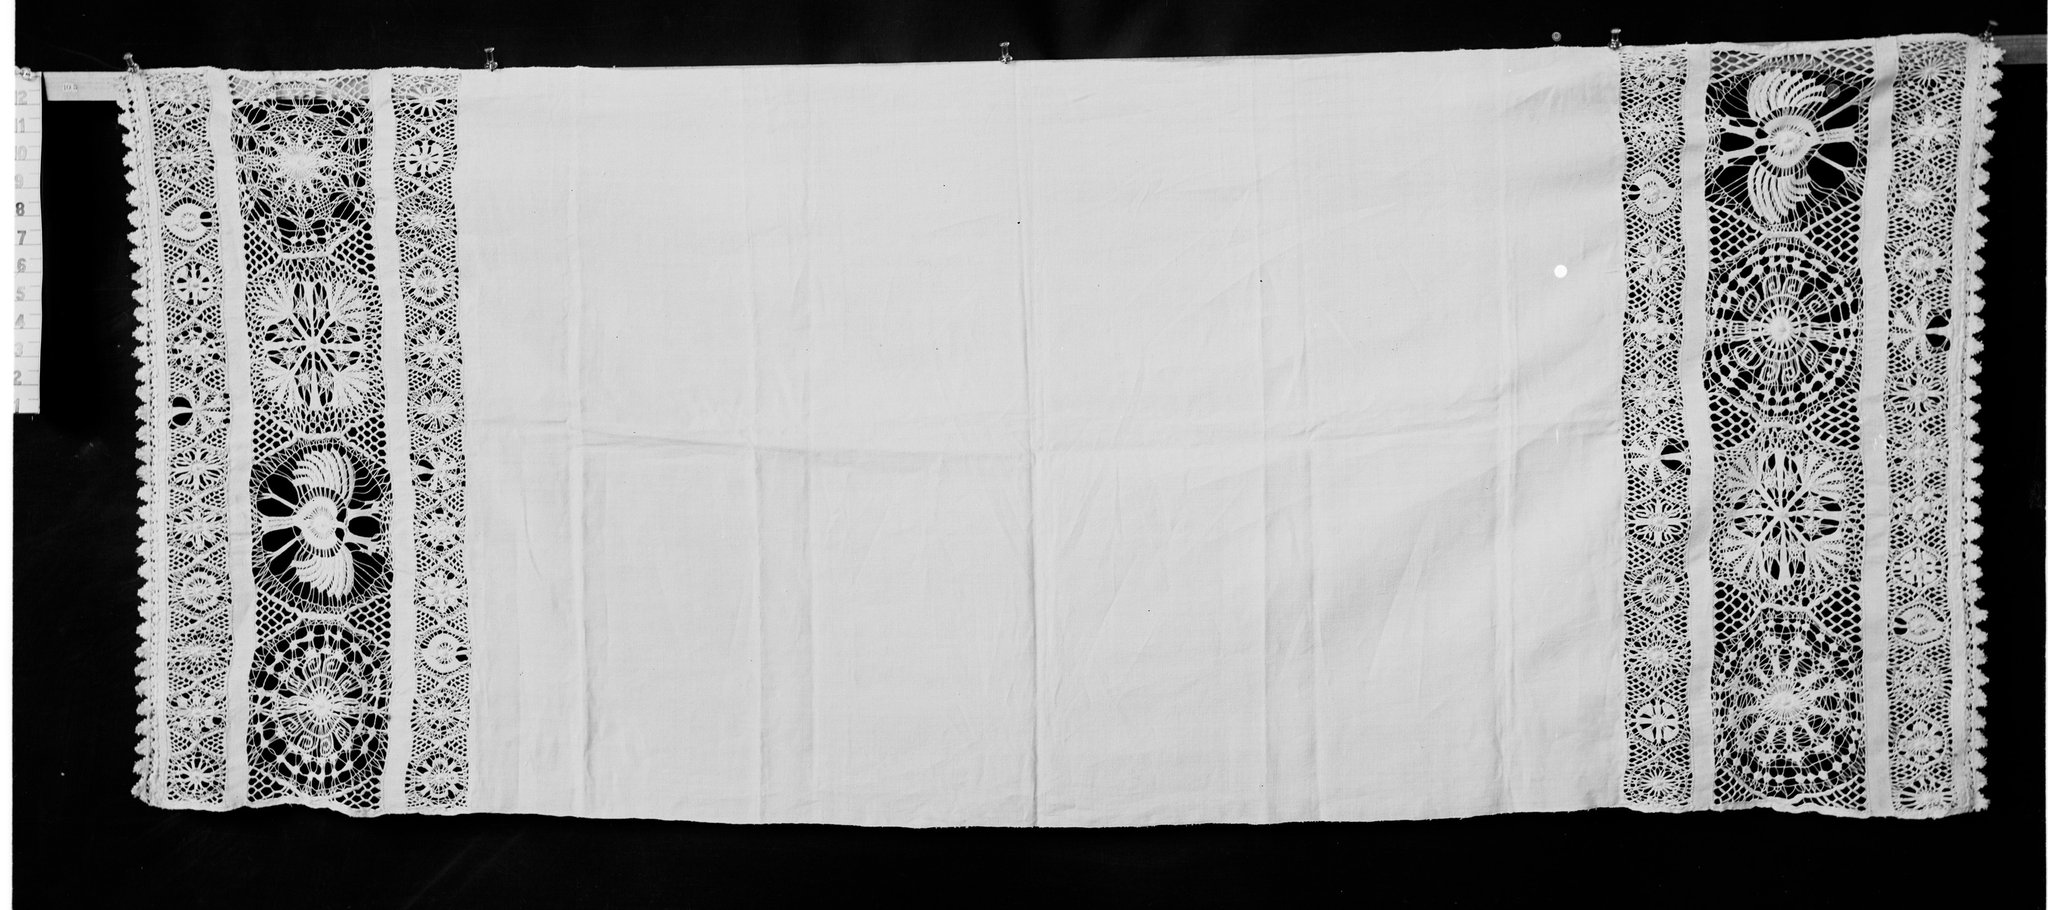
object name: cover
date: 1801-1900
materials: linen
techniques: embroidery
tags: birds